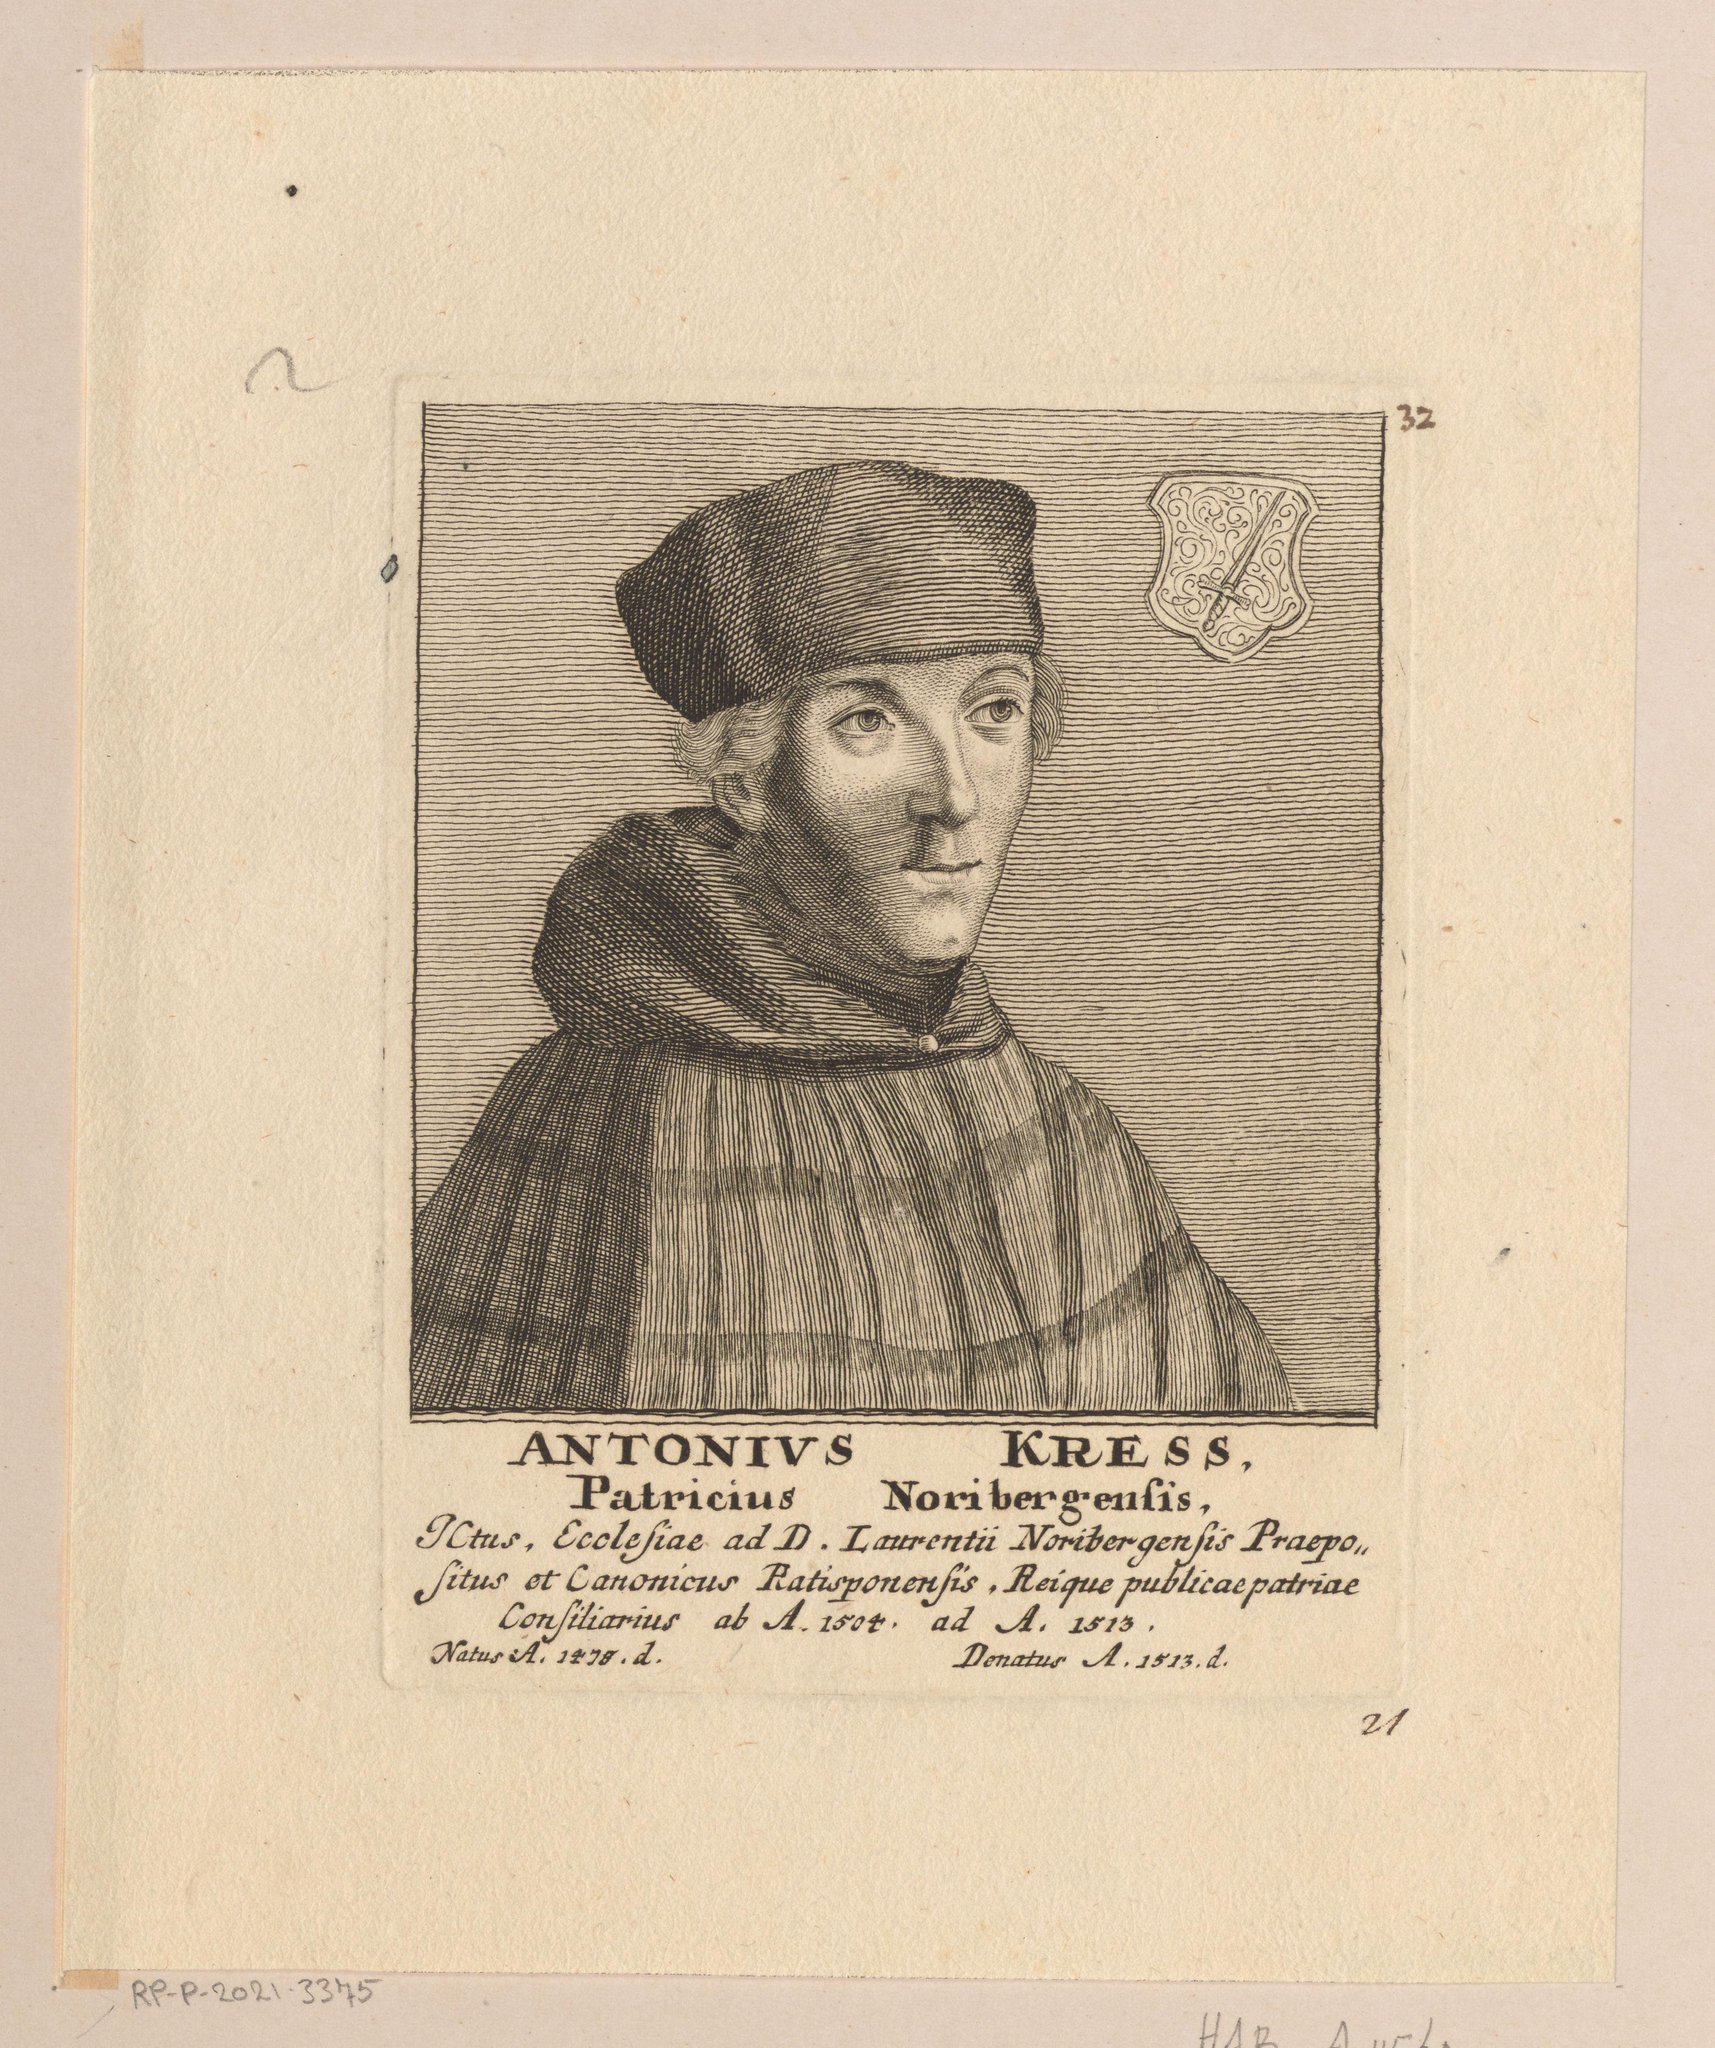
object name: print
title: Portret van Anton Kress von Kressenstein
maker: Anonymous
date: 1700-1749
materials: paper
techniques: engraving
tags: historical persons, armorial bearing, heraldry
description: Rechtsboven het portret zijn wapenschild.